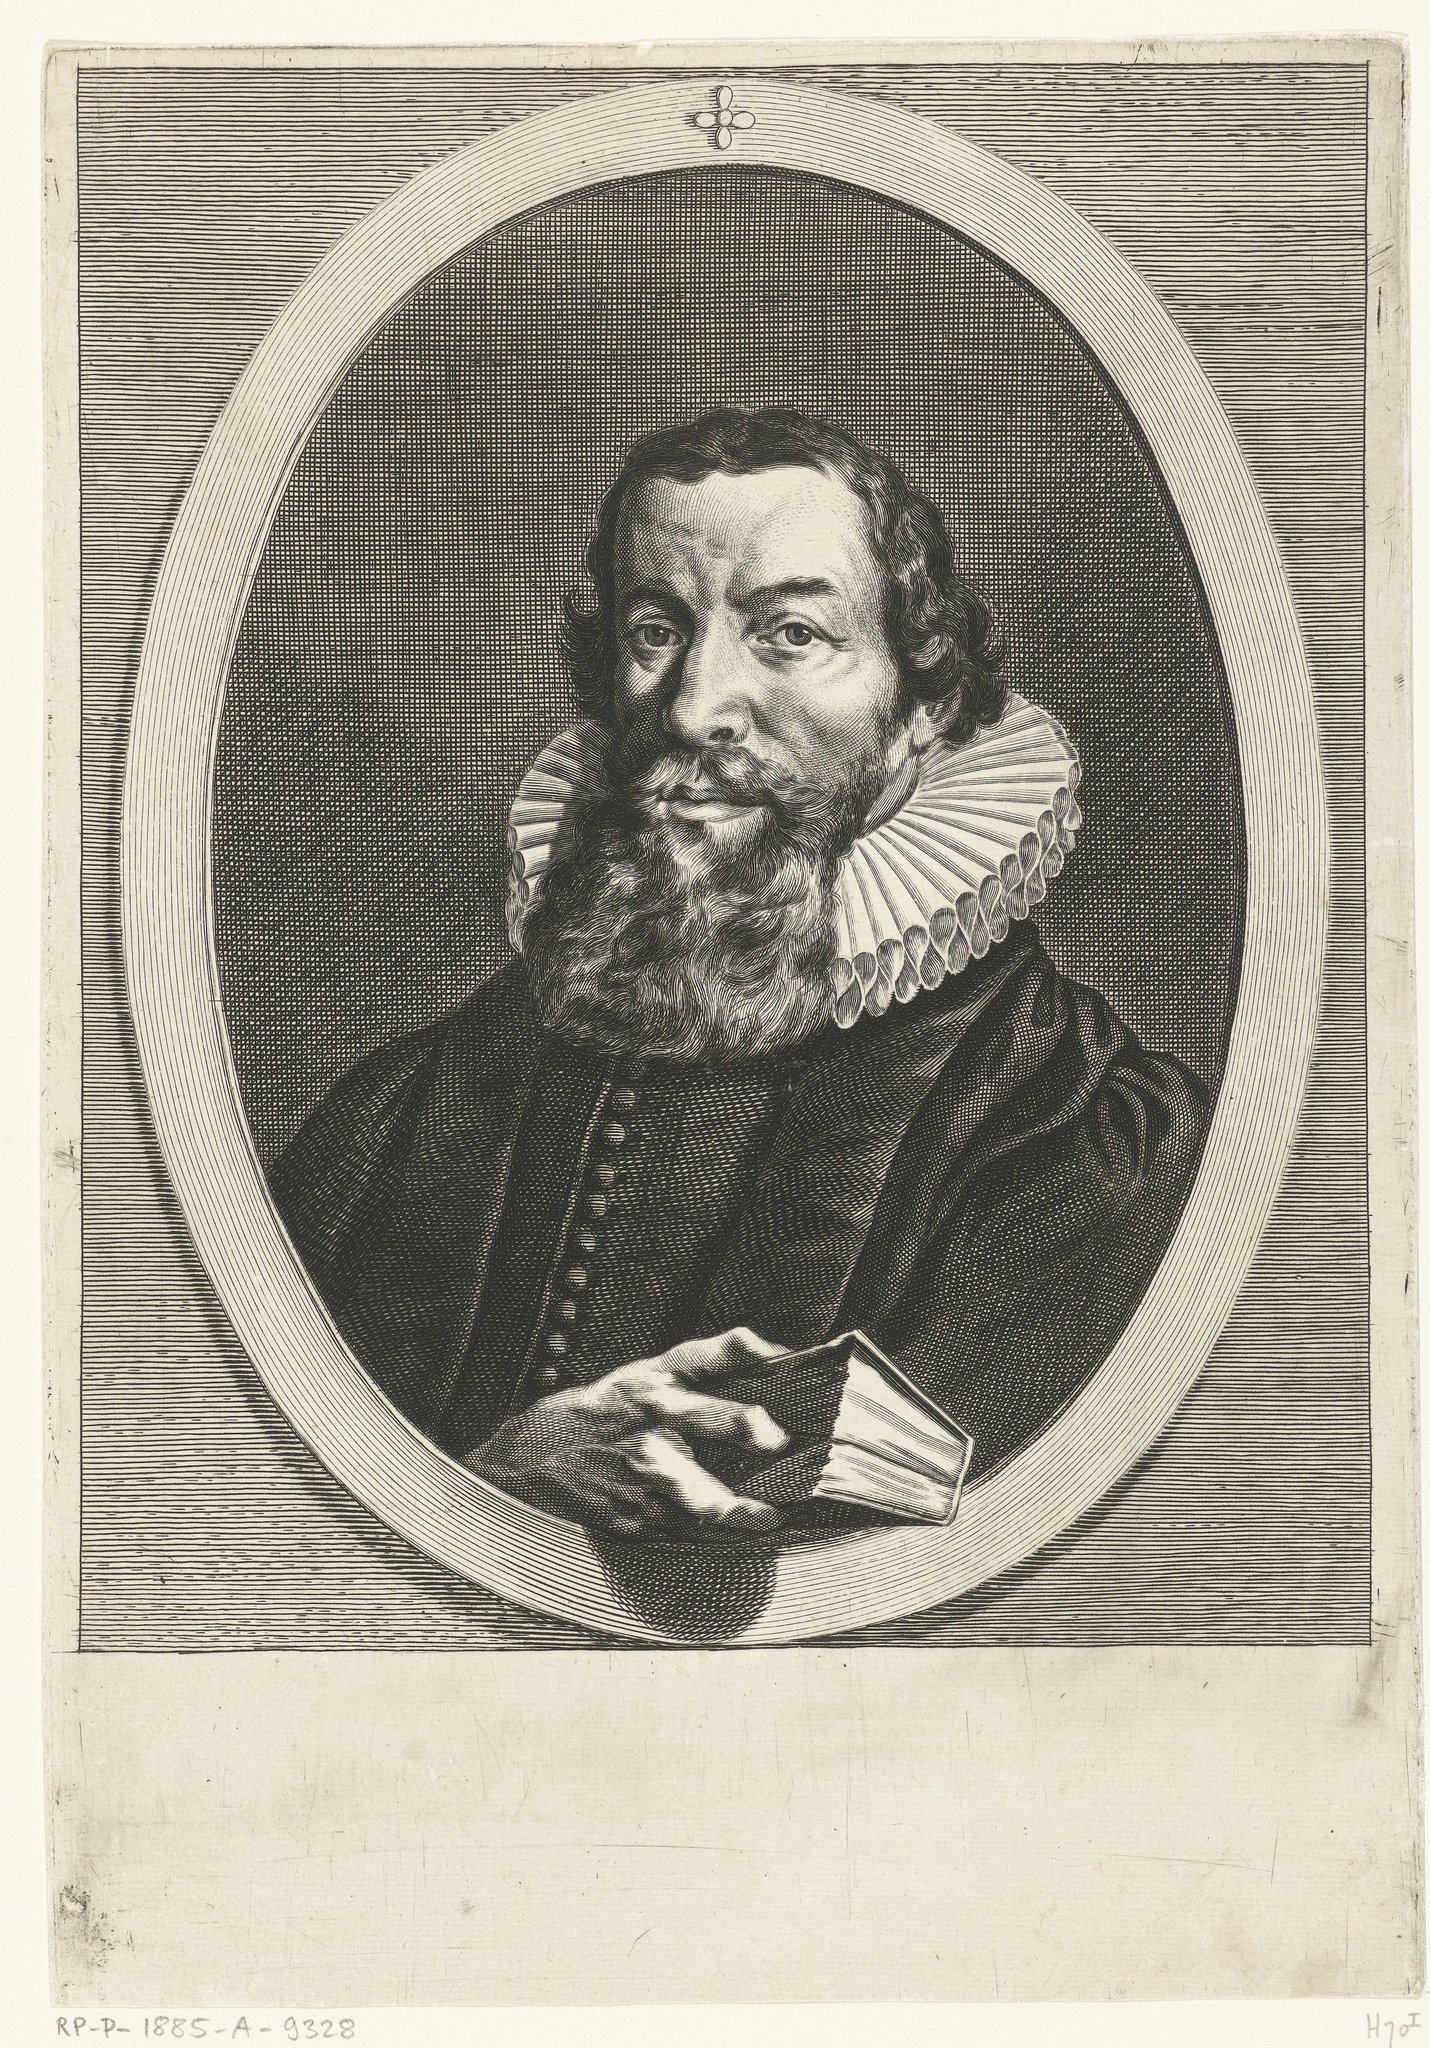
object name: print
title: Portret van Sigismund Philo Schelhammer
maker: hendrik bary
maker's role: draughtsman, print maker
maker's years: 1640-1707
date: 1657-1707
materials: paper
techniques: engraving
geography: netherlands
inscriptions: collector's mark: Lugt 2228